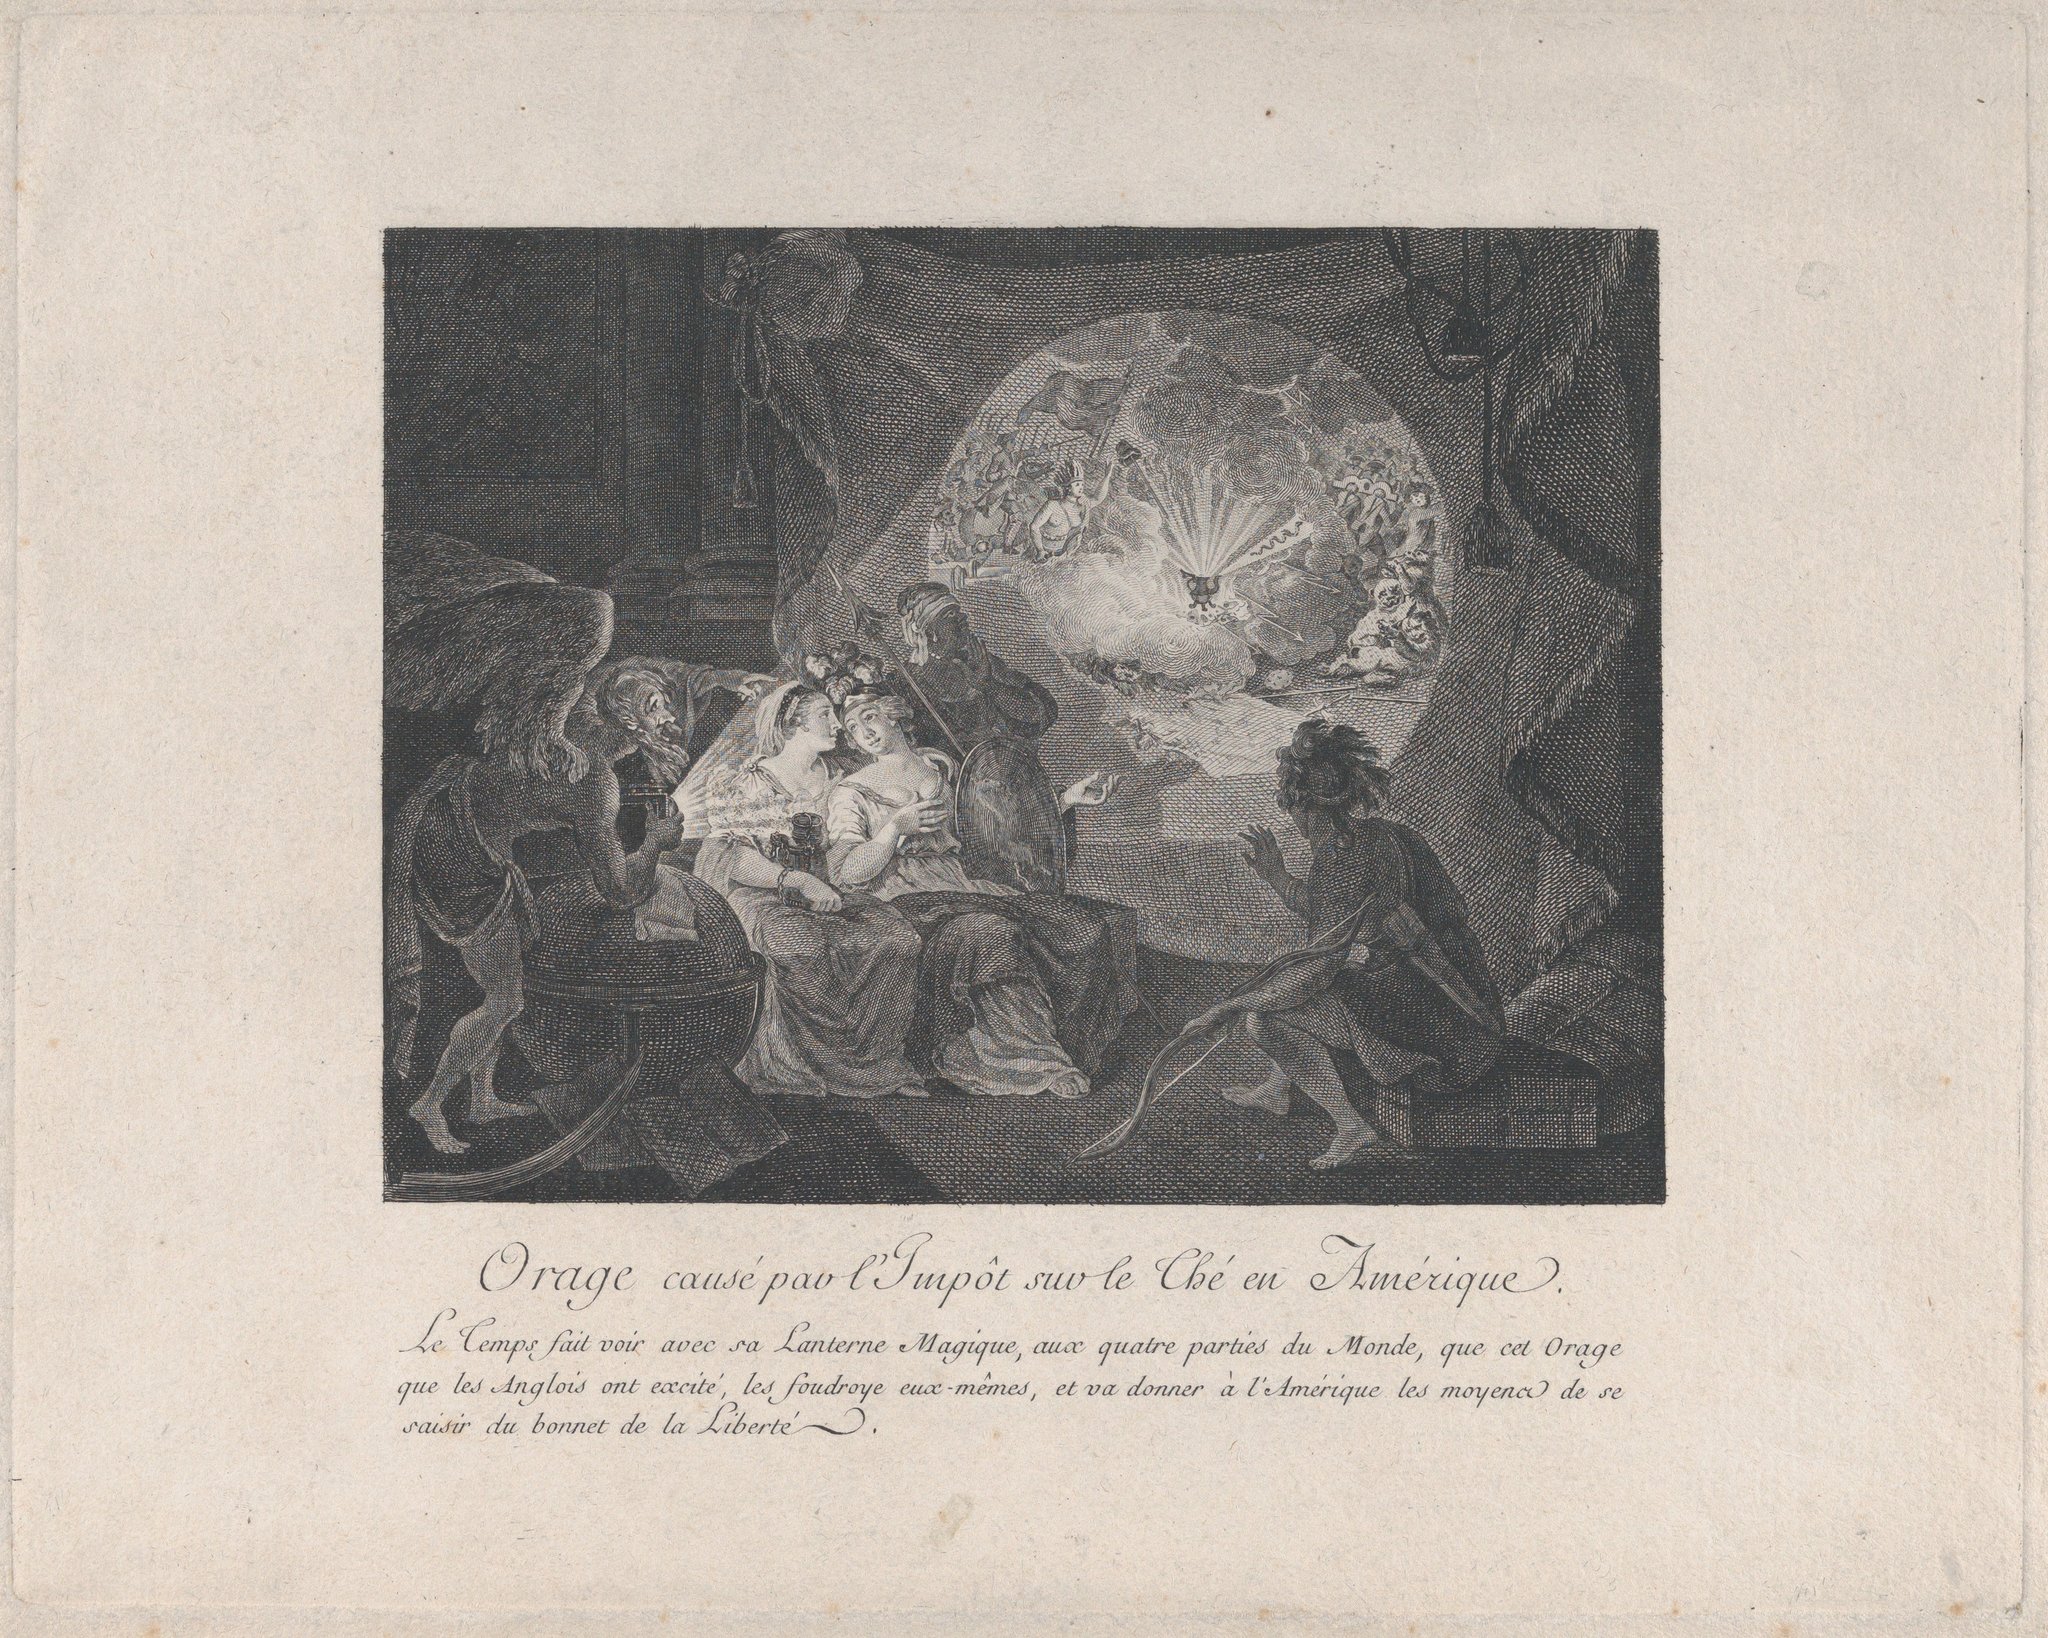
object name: print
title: Orage causé par l'Impôt sur le Thé en Amérique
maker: anonymous, french, 18th century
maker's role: engraver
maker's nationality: french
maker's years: 1700-1800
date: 1778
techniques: engraving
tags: satire,american revolution,men,women,politics